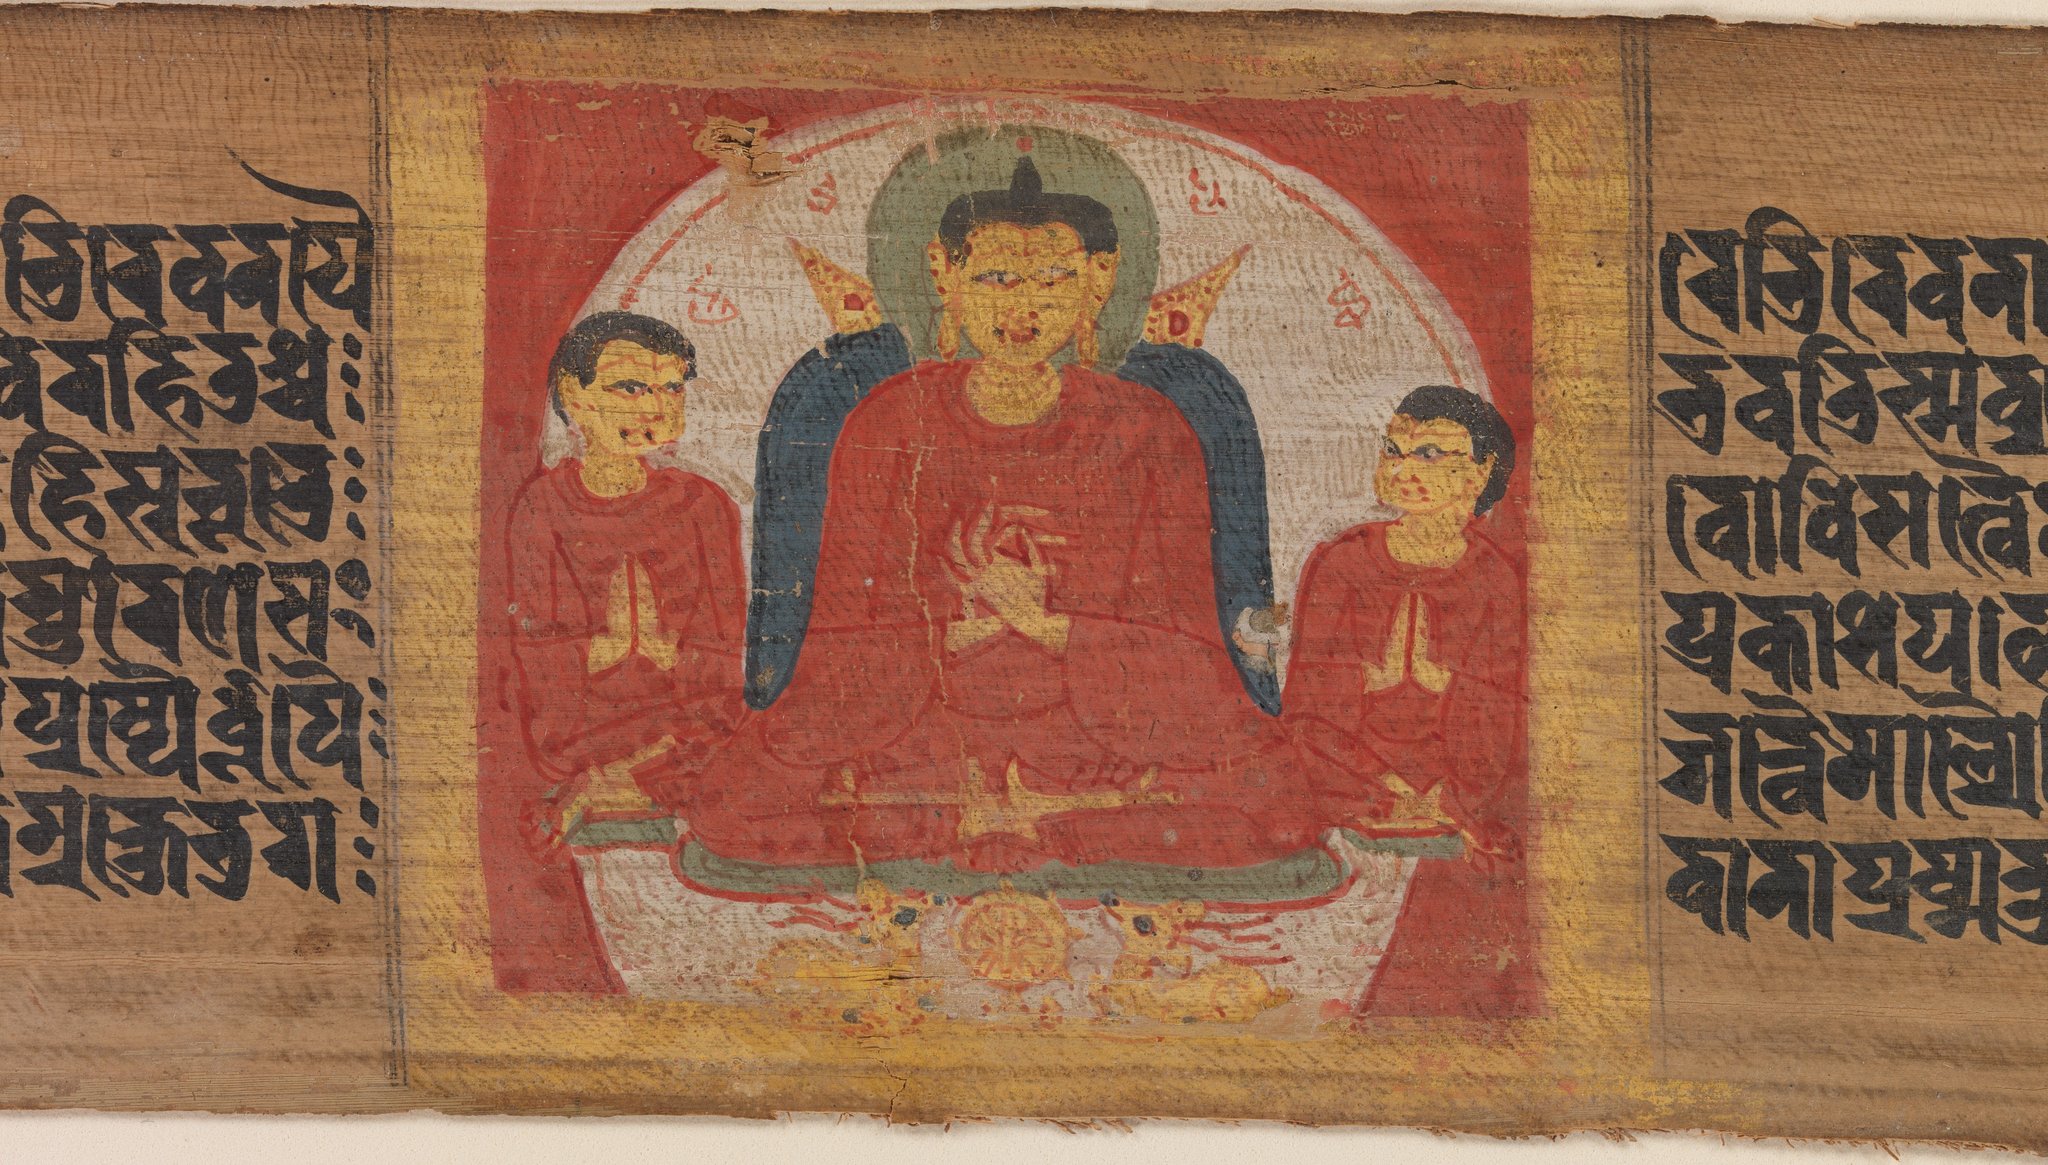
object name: folio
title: Buddha with His Hands Raised in Dharmacakra Mudra, Leaf from a dispersed Pancavimsatisahasrika Prajnaparamita Manuscript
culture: indian, bengal or bangladesh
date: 1090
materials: leaf, watercolor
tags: buddhism,buddha